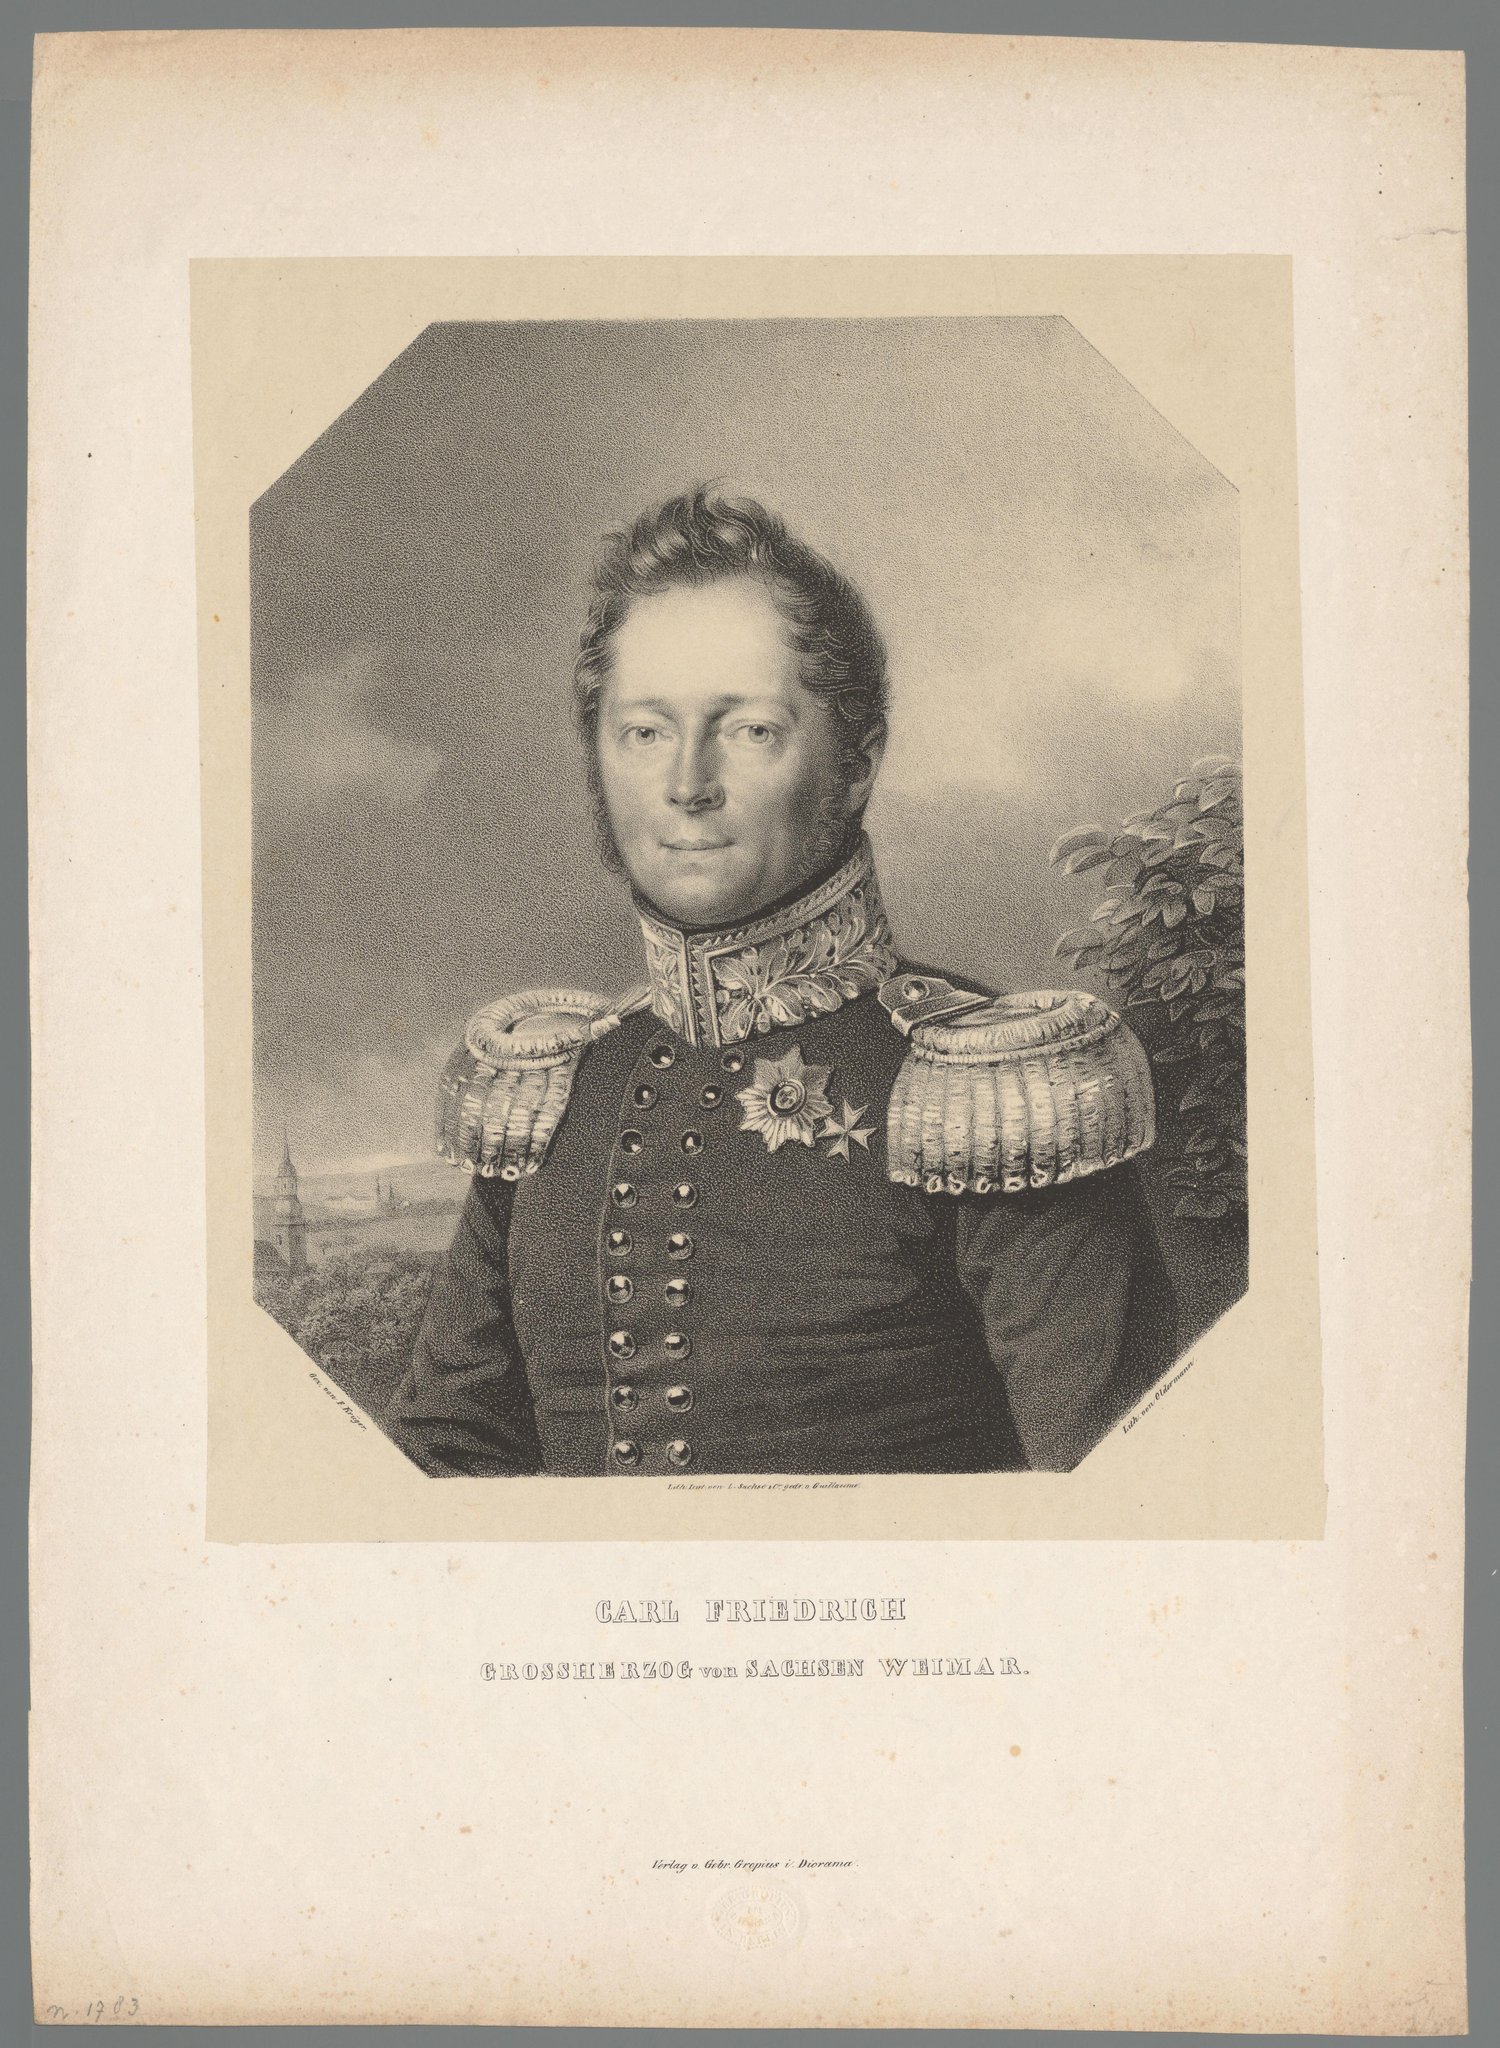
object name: print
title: Portret van Karl Friedrich von Sachsen-Weimar-Eisenach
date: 1812-1874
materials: paper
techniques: lithograph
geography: berlin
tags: adult man, historical persons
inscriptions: check stamp: Lugt 5415, collector's mark: Lugt 2228